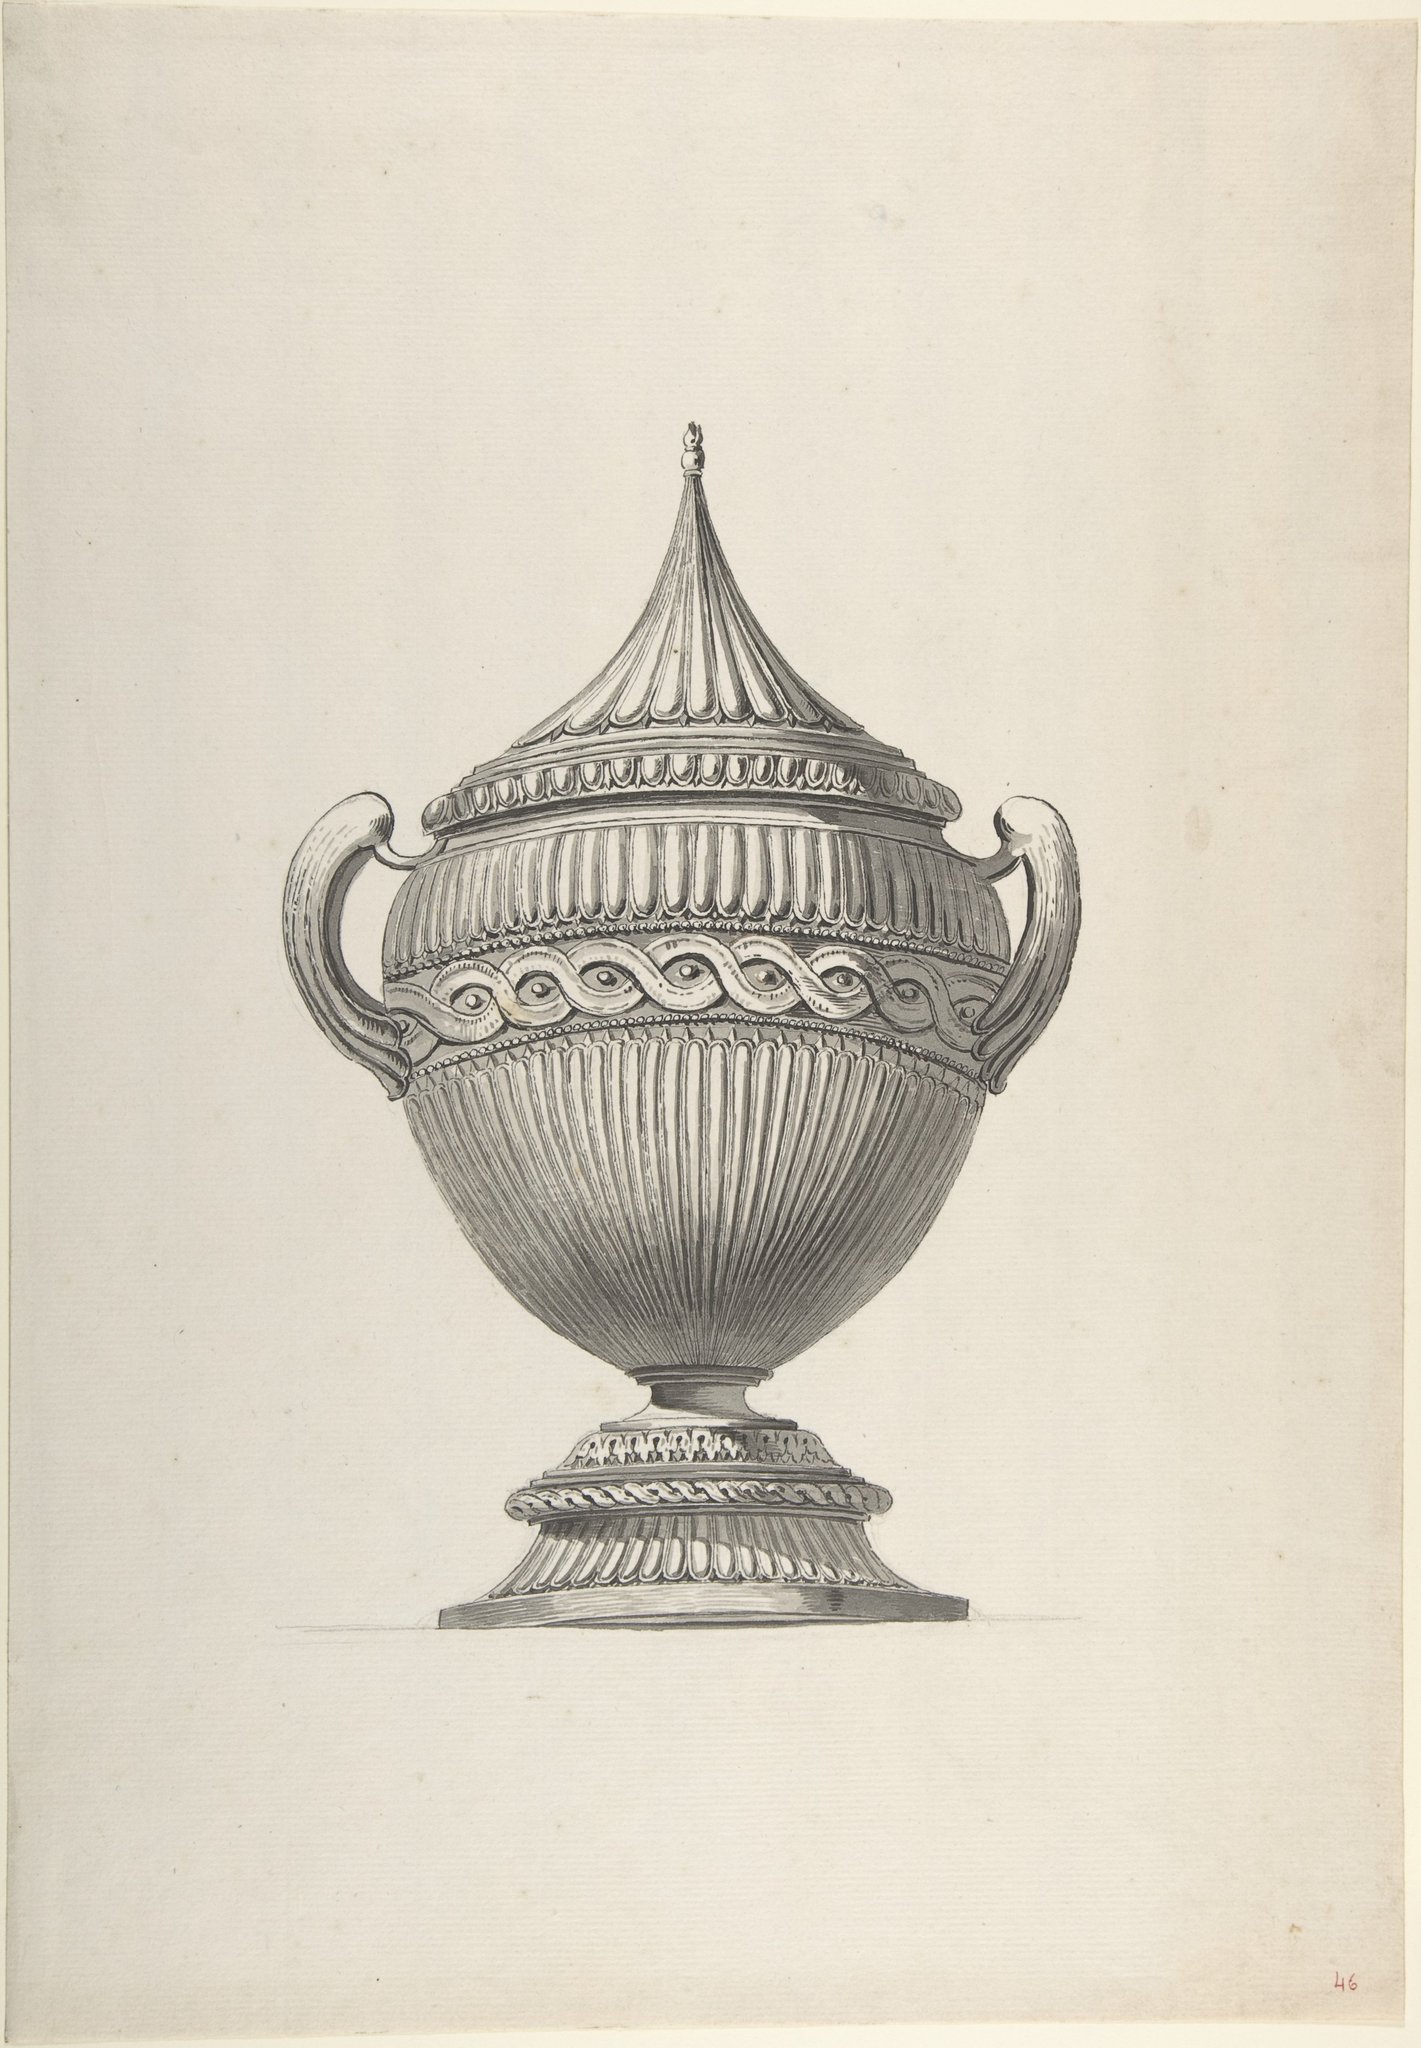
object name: drawing ornament architecture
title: Design for an Urn with a Pointed Lid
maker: anonymous, french, 18th century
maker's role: artist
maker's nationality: french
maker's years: 1700-1800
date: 1770-1790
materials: ink, drawing material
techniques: brush, pen, wash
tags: urns